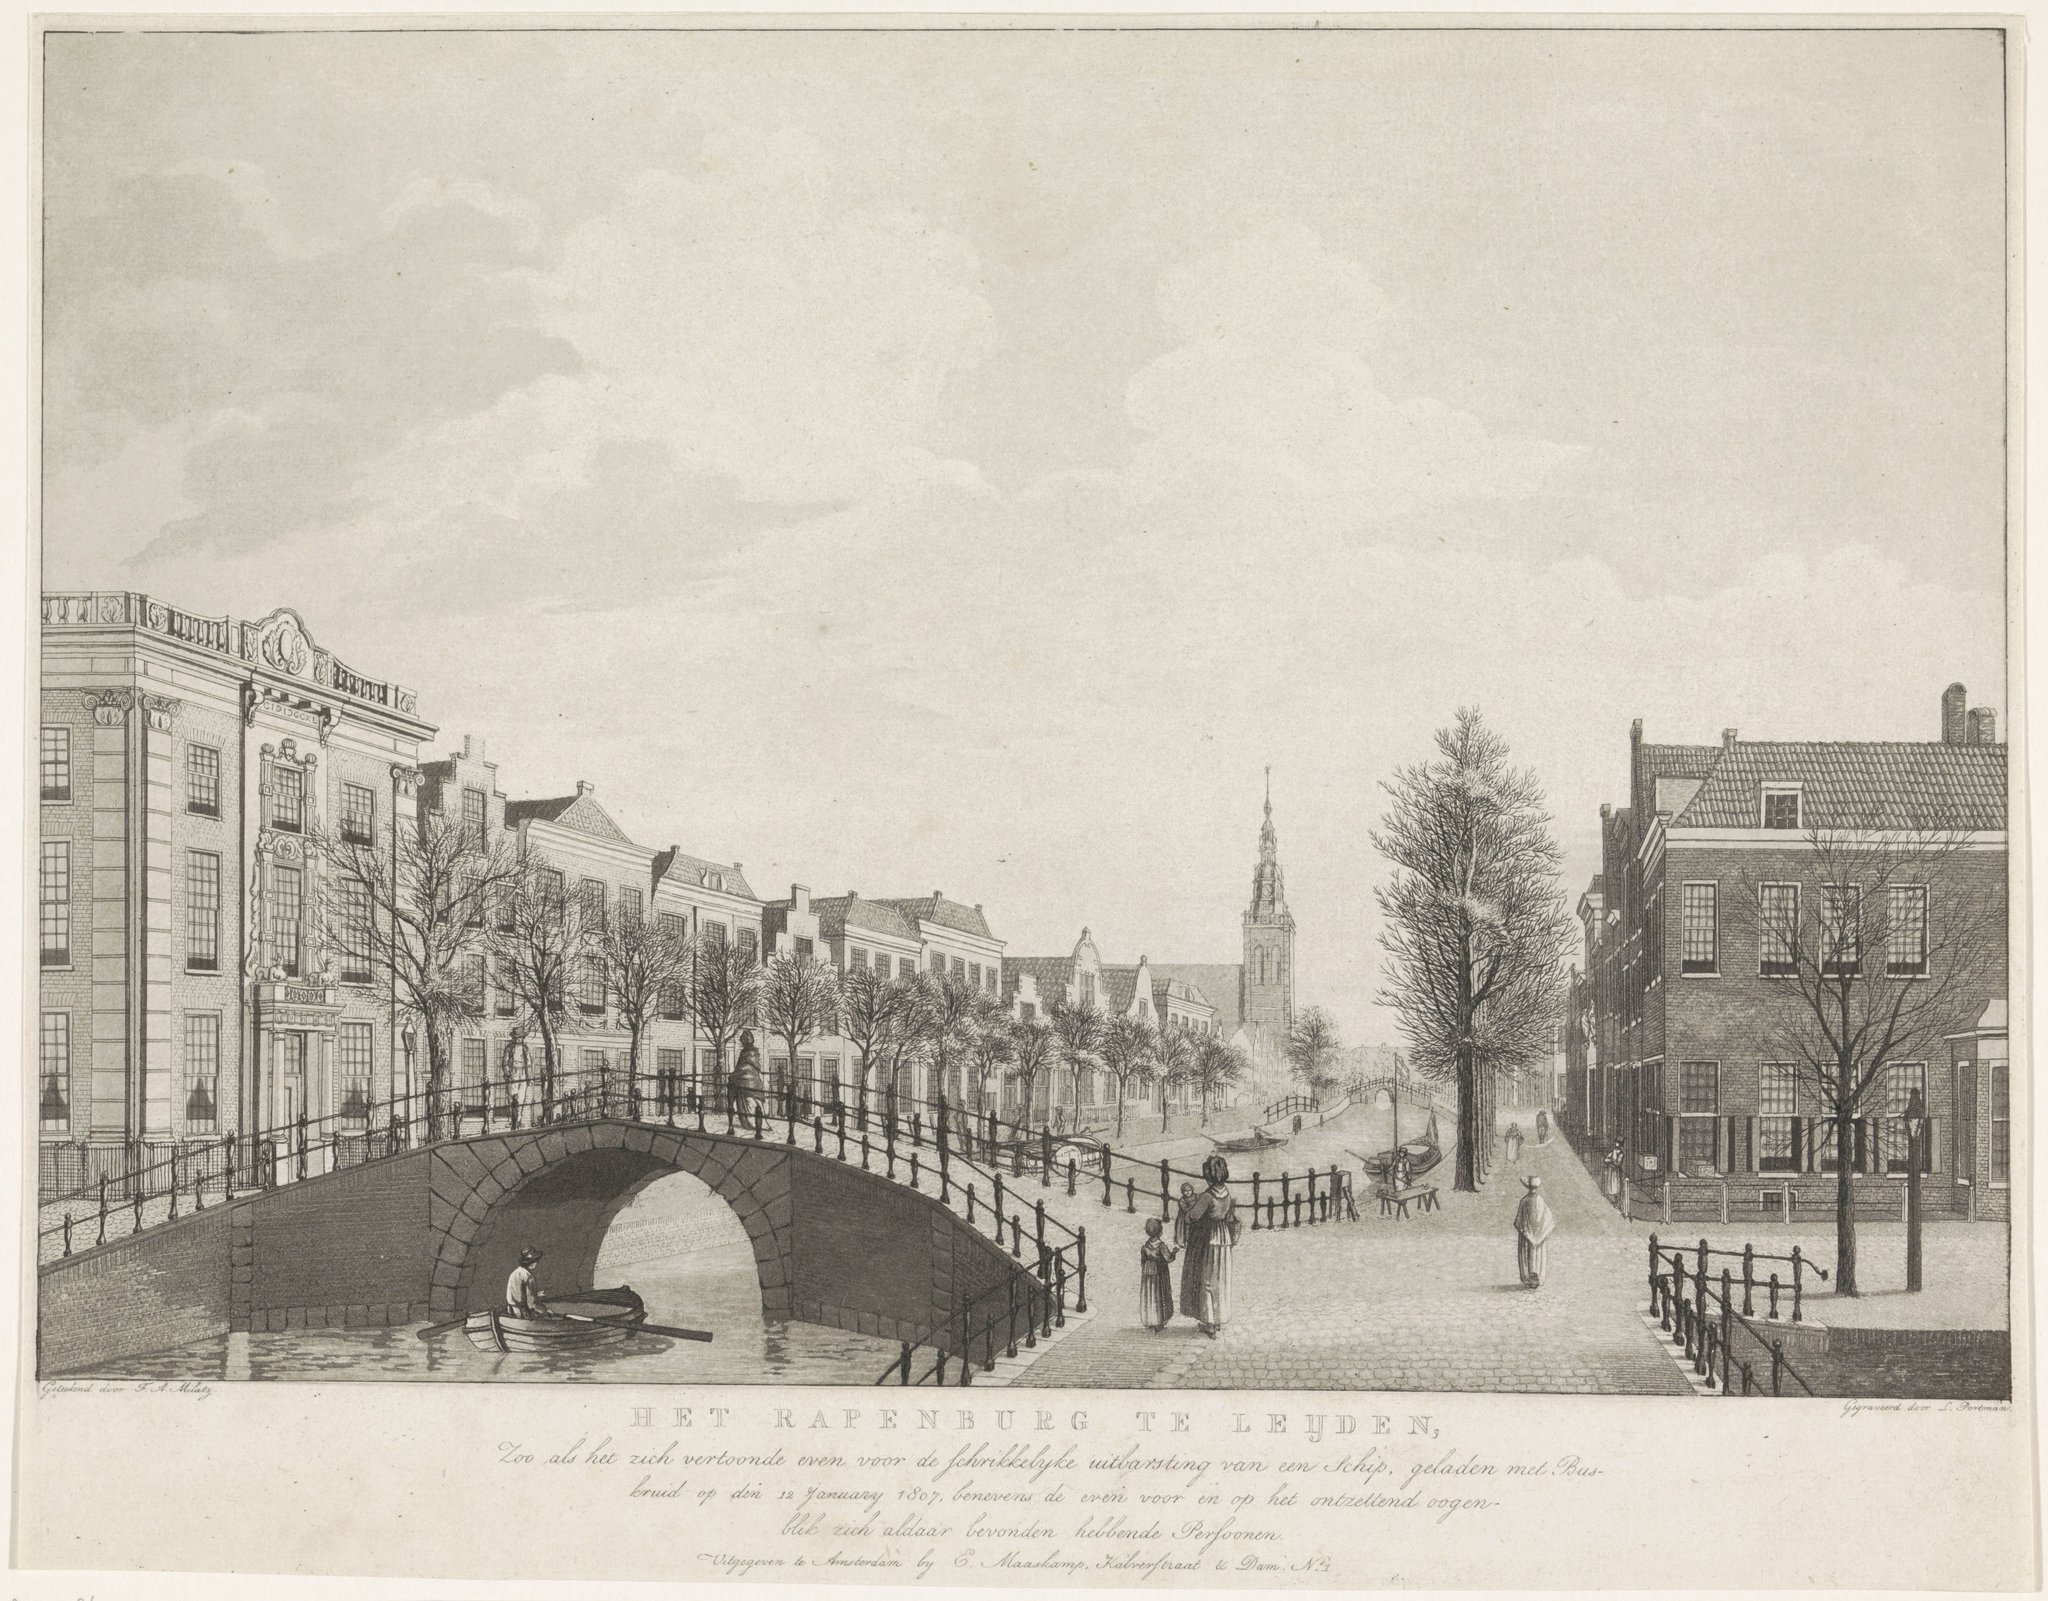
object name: print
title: Het Rapenburg te Leijden, zoo als het zich vertoonde even voor de schrikkelijke uitbarsting (...)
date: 1807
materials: paper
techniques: aquatint, etching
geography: netherlands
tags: city-view in general; 'veduta'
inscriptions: collector's mark: Lugt 2228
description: Gezicht op het het Steenschuur, een gracht in het verlengde van het Rapenburg, te Leiden, in welstand vóór de buskruitramp van 12 januari 1807. Op de voorgrond de Nieuwsteegbrug, na de brug het Steenschuur met in de verte de Saaihal of Sint Lodewijkskerk.